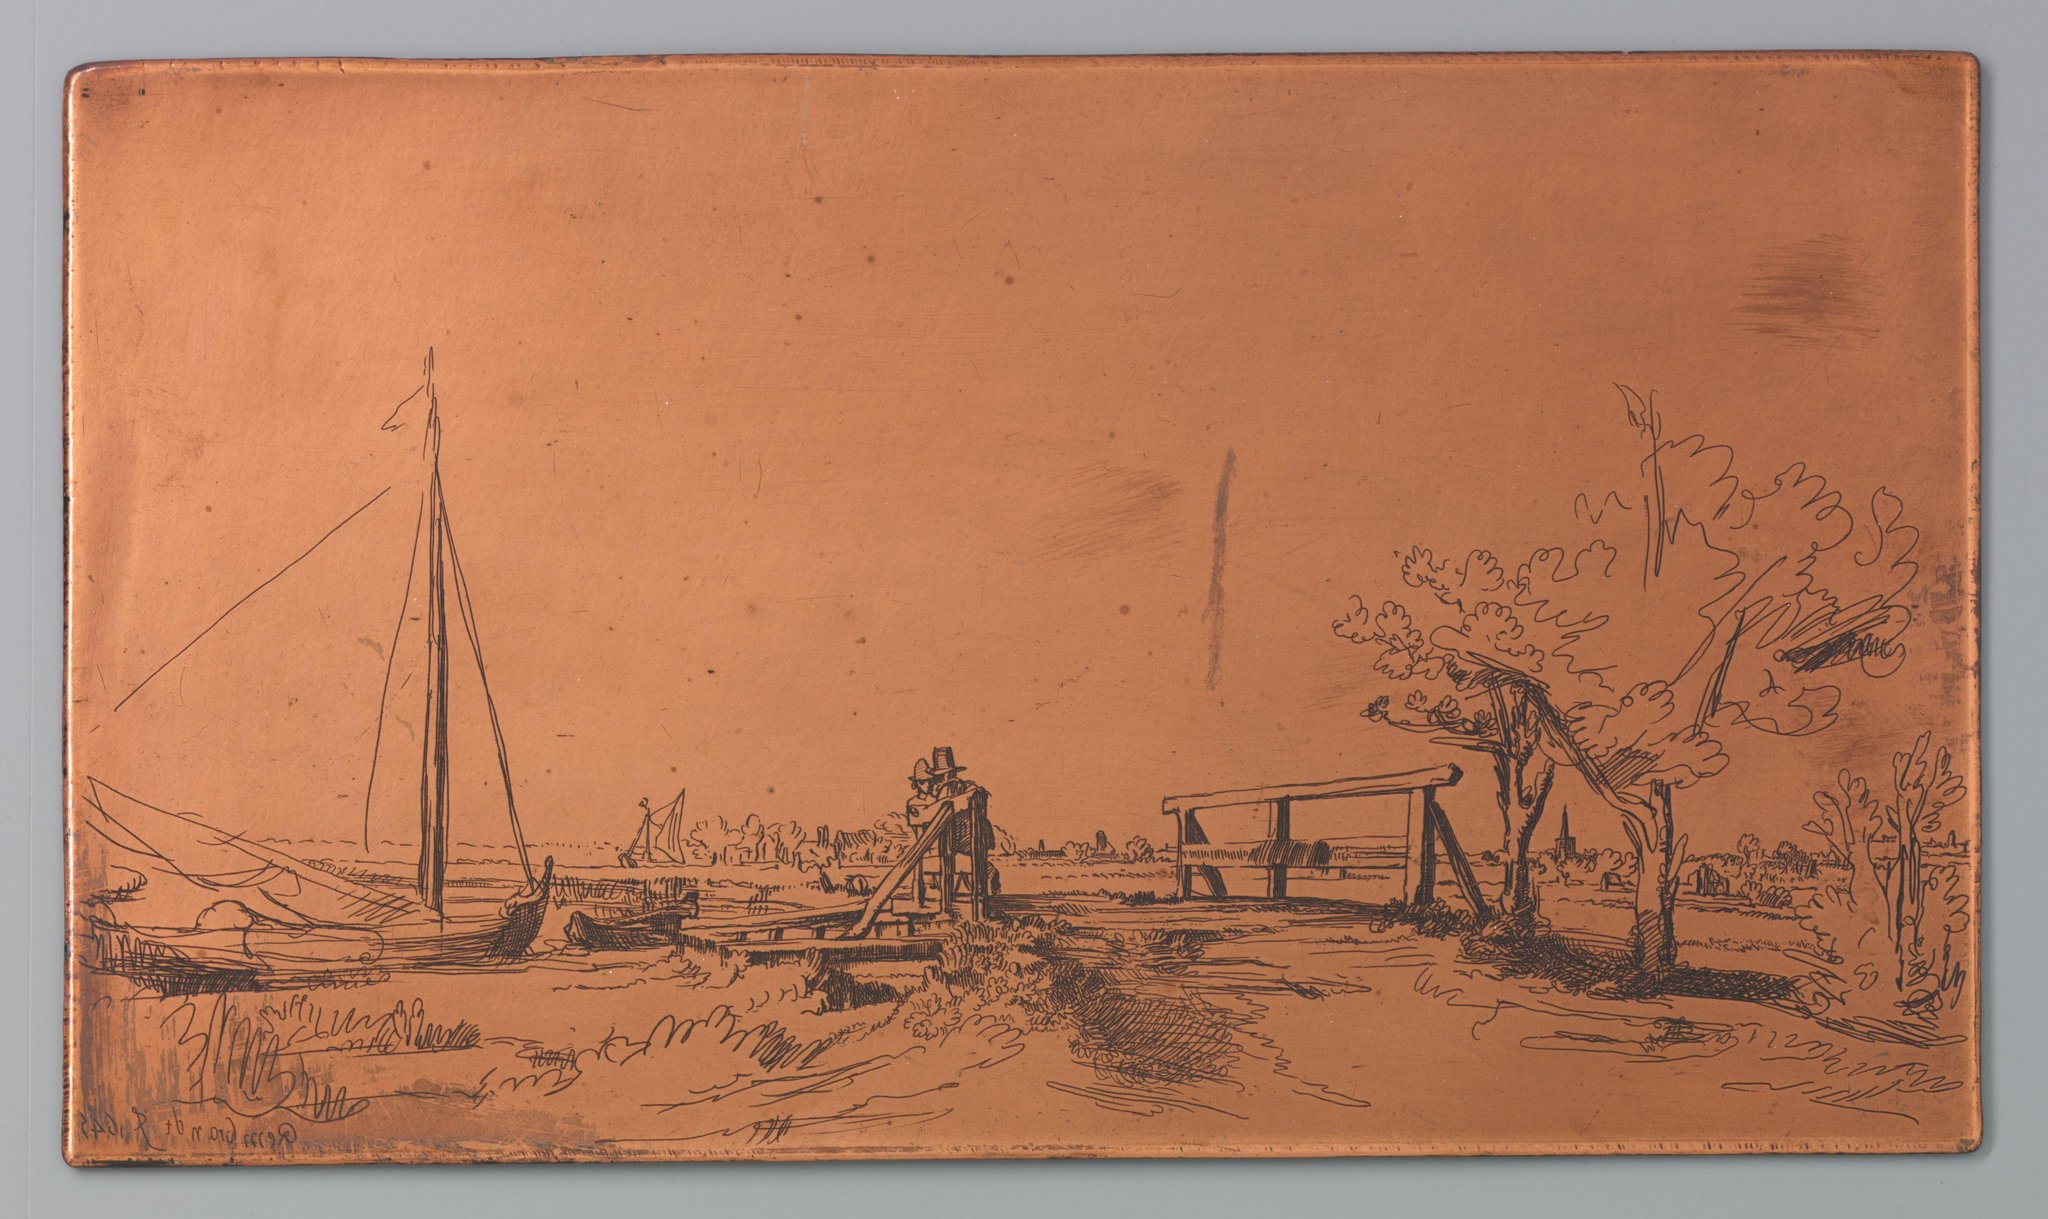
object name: copper plate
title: The bridge at Klein Kostverloren on the Amstel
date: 1807-1809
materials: copper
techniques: etching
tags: landscape with bridge, viaduct or aqueduct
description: Afdrukken van deze plaat zijn voor het eerst gebruikt in: Recueil de Quatre-Vingt-Cinq estampes originales, têtes, paysages et différens sujets, dessinées et gravées par Rembrandt (...). Parijs: Henry-Louis Basan, 1807-1809. De precieze locatie van de voorstelling is onduidelijk. Lang werd het geduid als een bruggetje bij buitenplaats Klein-Kostverloren met gezicht op Ouderkerk aan de Amstel, maar het zou ook aan de Bullewijk onder Ouderkerk kunnen zijn (zie documentatie, De Winkel).